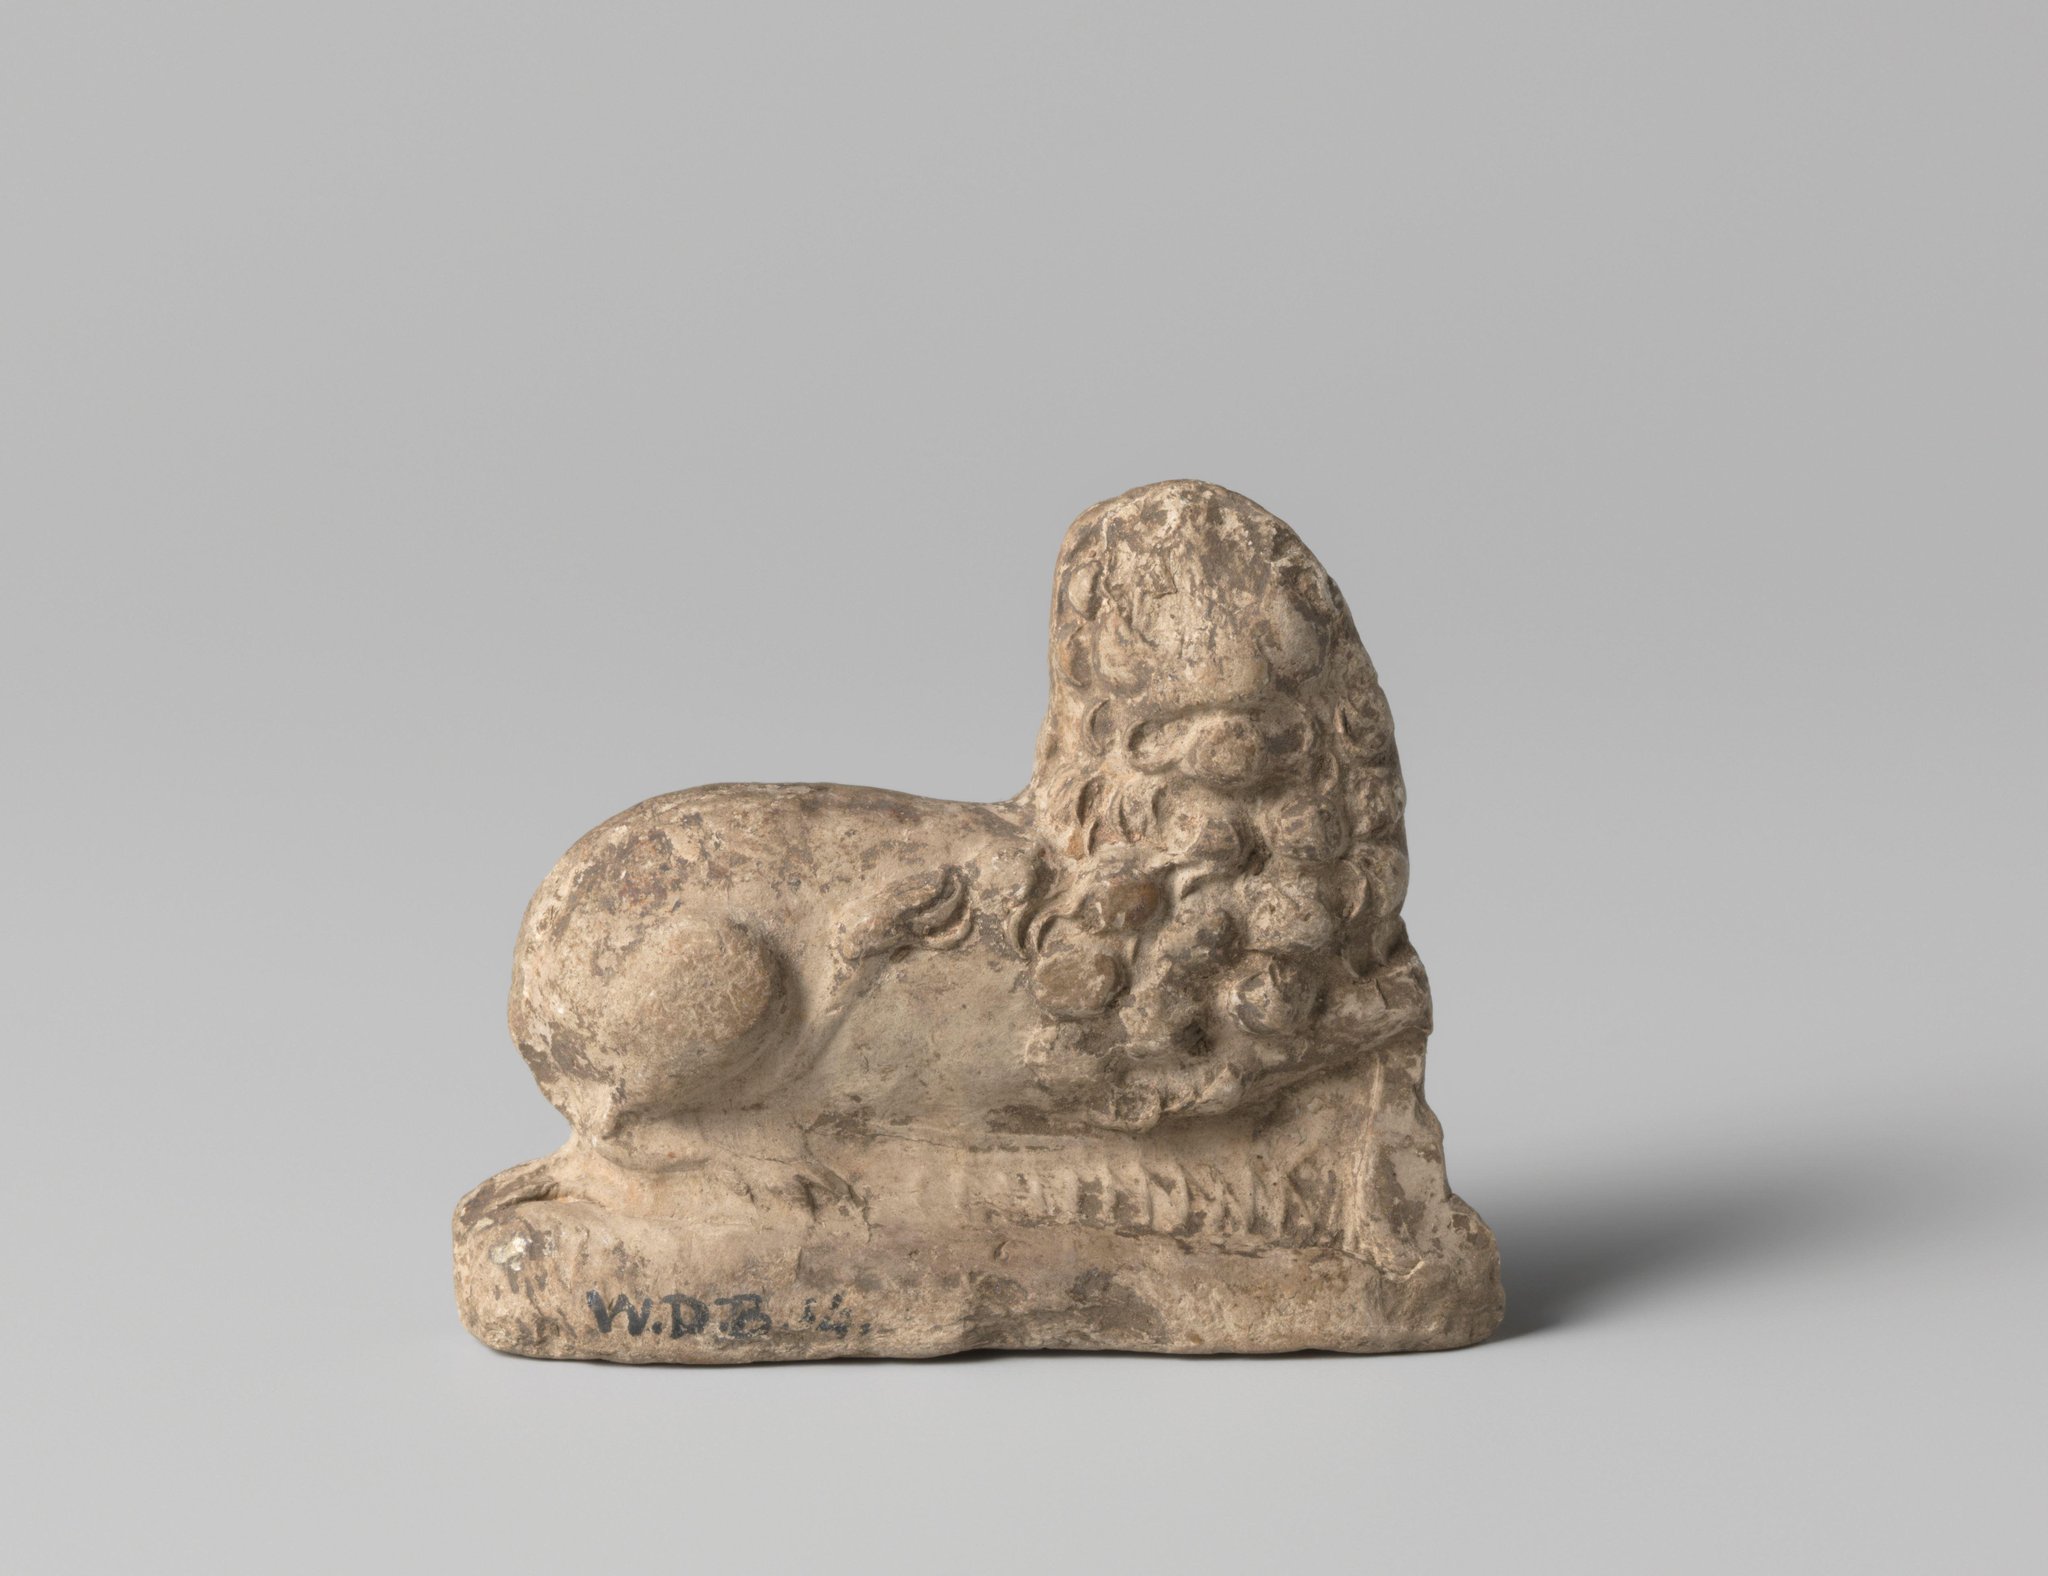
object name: sculpture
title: Beeldhouwwerk in de vorm van een liggende leeuw.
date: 1400-1950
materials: stone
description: Beeldhouwwerk in de vorm van een liggende leeuw.